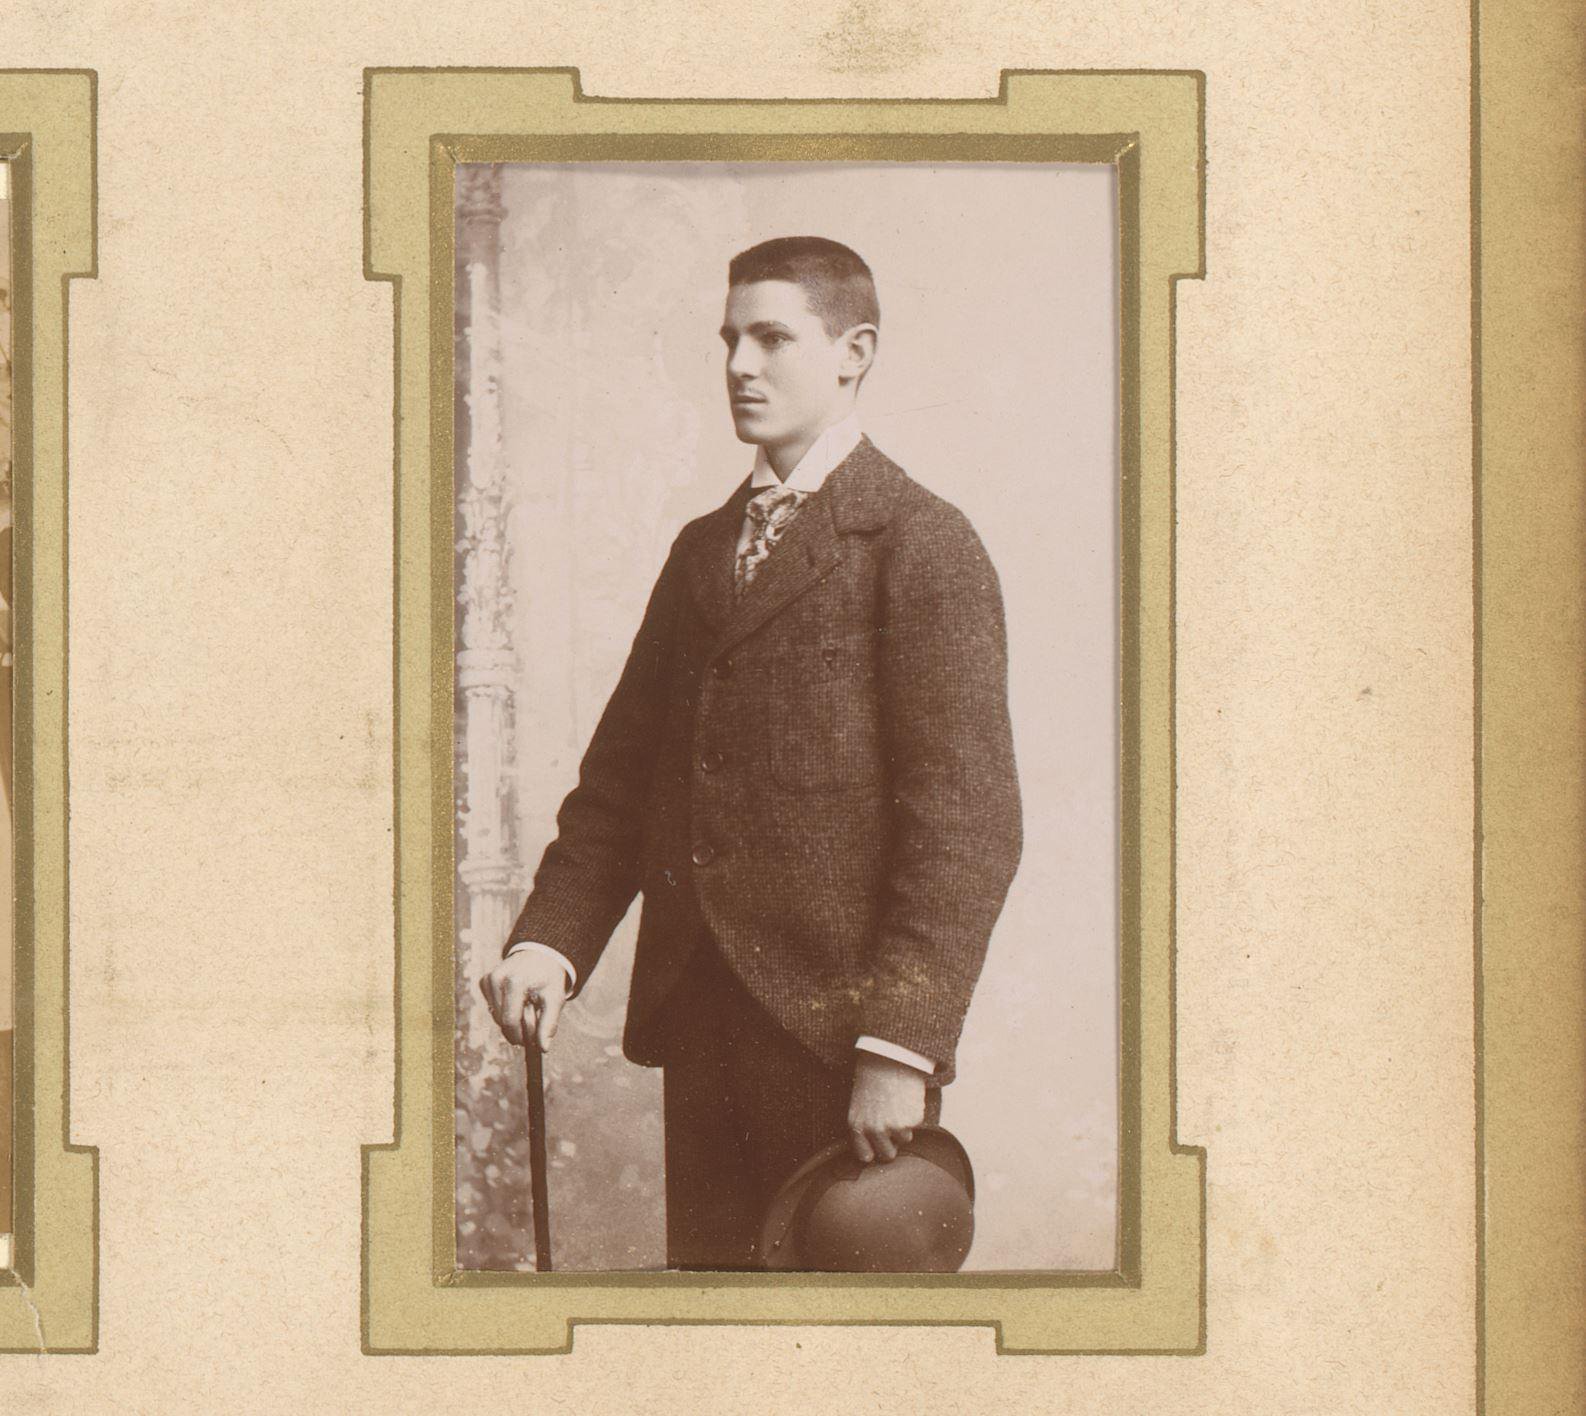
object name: photograph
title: Portret van een jongeman met bolhoed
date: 1897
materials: cardboard, photographic support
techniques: gelatin silver print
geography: ghent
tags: historical persons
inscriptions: inscription: ‘Ch. De Trez et Simon/ Gand/ Rue de la Corne 1 (...)’, annotation: ‘[...] le 21 mai, 1897’